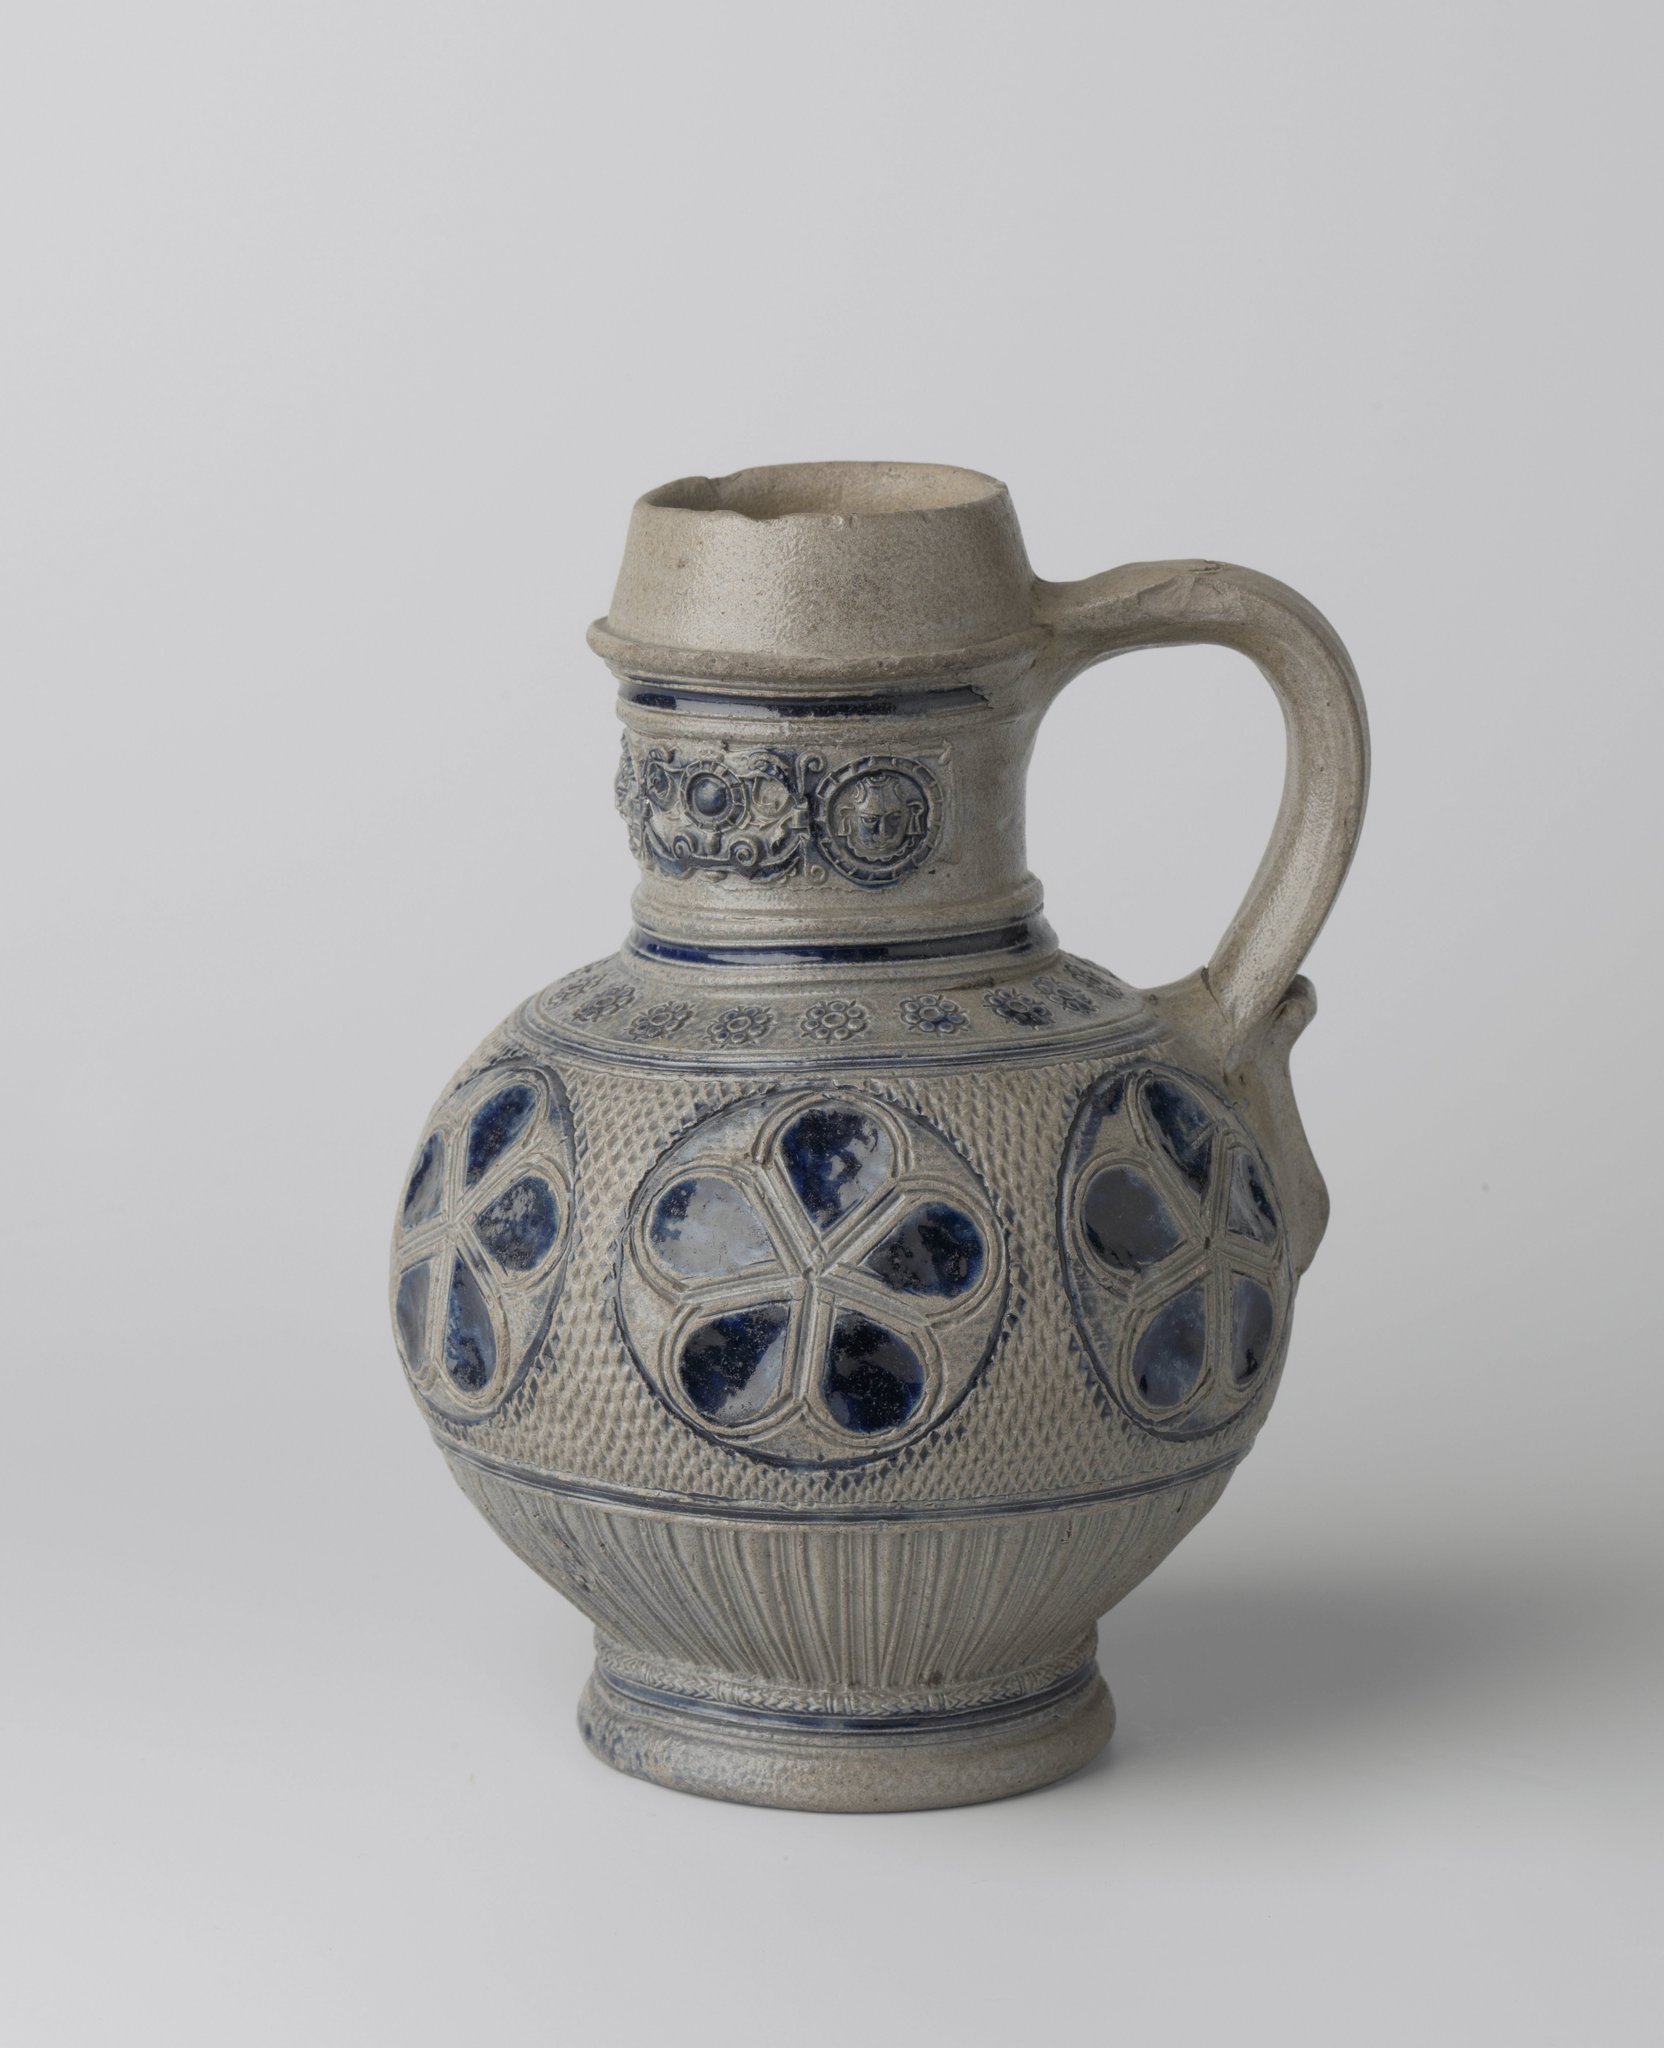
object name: jug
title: Jug with medallions and roundels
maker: Anonymous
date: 1600-1630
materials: cobalt, glaze, stoneware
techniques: printing, firing, forming, relief, turning, vitrification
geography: raeren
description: Kruik van steengoed op standring met een bolvormig lichaam en wijde nek. Het C-vormige oor is bevestigd aan de nek en de schouder. Profielen op de nek en voet. Gedeeltelijk bedekt met kobaltblauw. Op de buik een band met kerfsnede met daarin uitgespaard zes medaillons met een rozet. Het onderste deel van de buik met canelures en op de schouder een band met gestempelde rozetten. De nek met in reliëf een gedrukte en opgelegde band met rolwerk onderbroken door medaillons met een masker. Raeren.